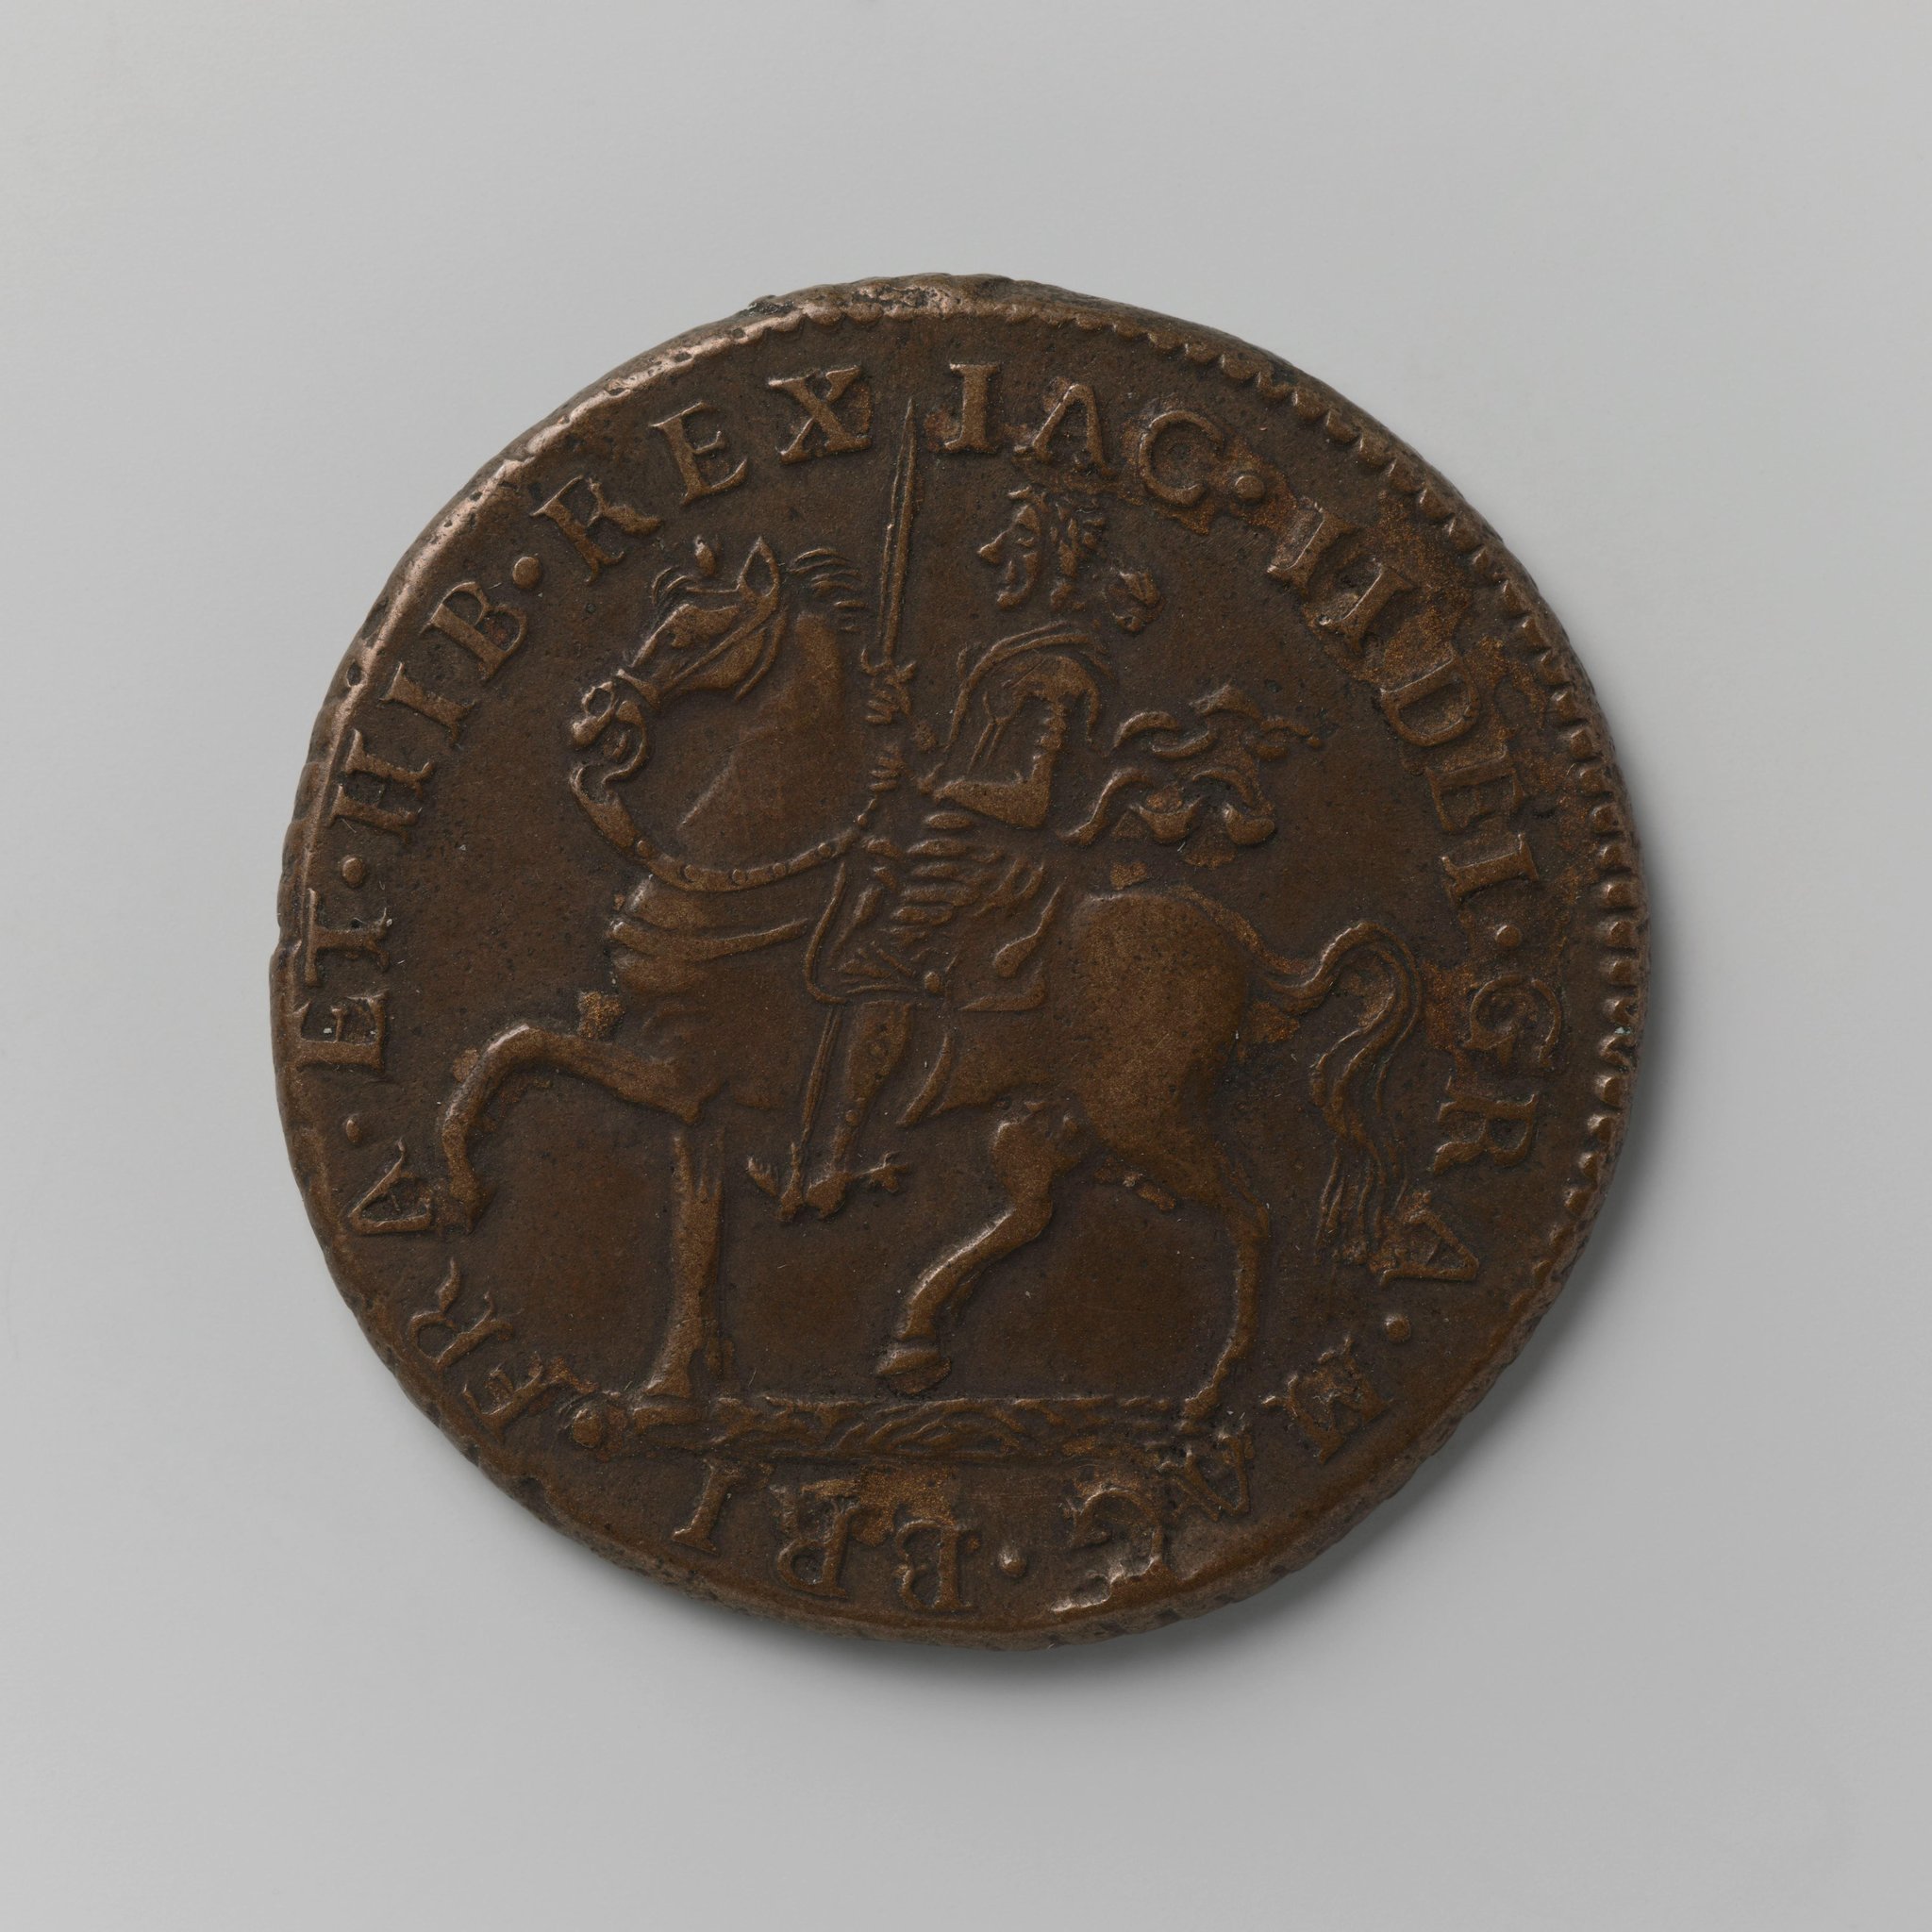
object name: coin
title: Ierland, Jacobus II, crown, 1690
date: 1690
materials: bronze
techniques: striking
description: Bronzen munt. Voorzijde: vorst met in rechterhand zwaard te paard naar links. Keerzijde: kroon, waaromheen in kruisvorm vier gekroonde wapenschilden. In de hoeken jaartal. Bloemrand. Gun-money.